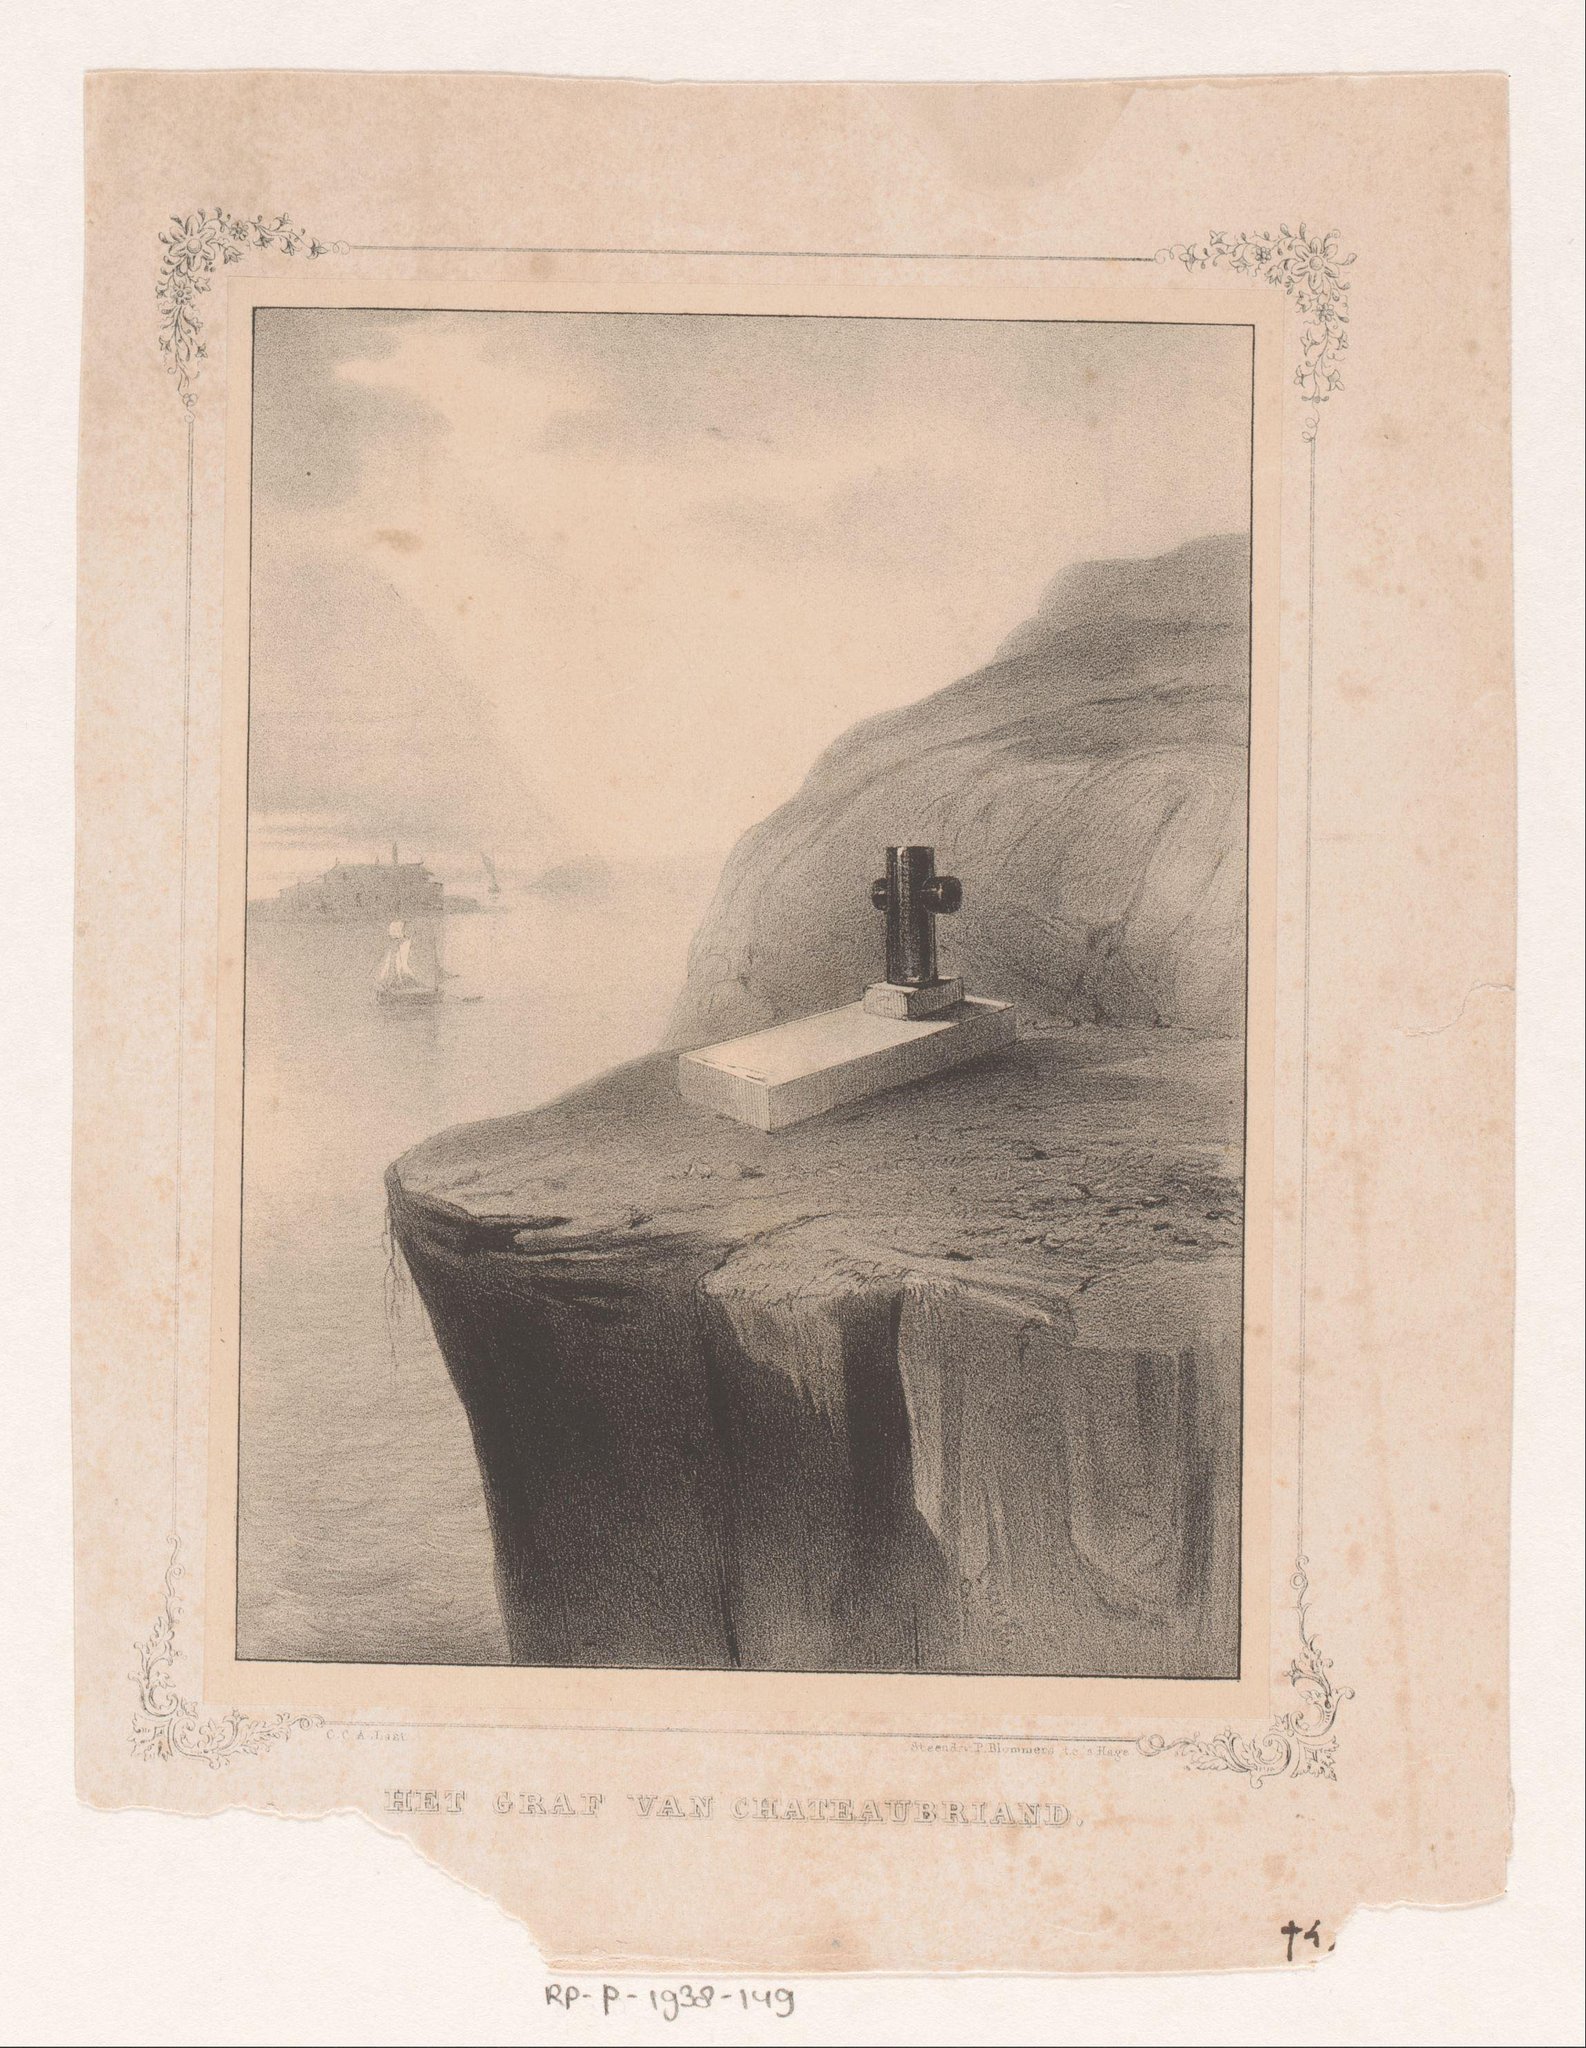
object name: print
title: Graf van François René de Chateaubriand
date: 1842-1887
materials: paper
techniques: lithograph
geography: the hague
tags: paris, politician, françois-rené de chateaubriand, grave, tomb, coastal cliff or crag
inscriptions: collector's mark: Lugt 2228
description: Het graf ligt op een klif met uitzicht over de zee. Het bevindt zich op het Franse eiland Grand-Bé, bij Saint-Malo. Om de afbeelding een sierrand met bloemen.